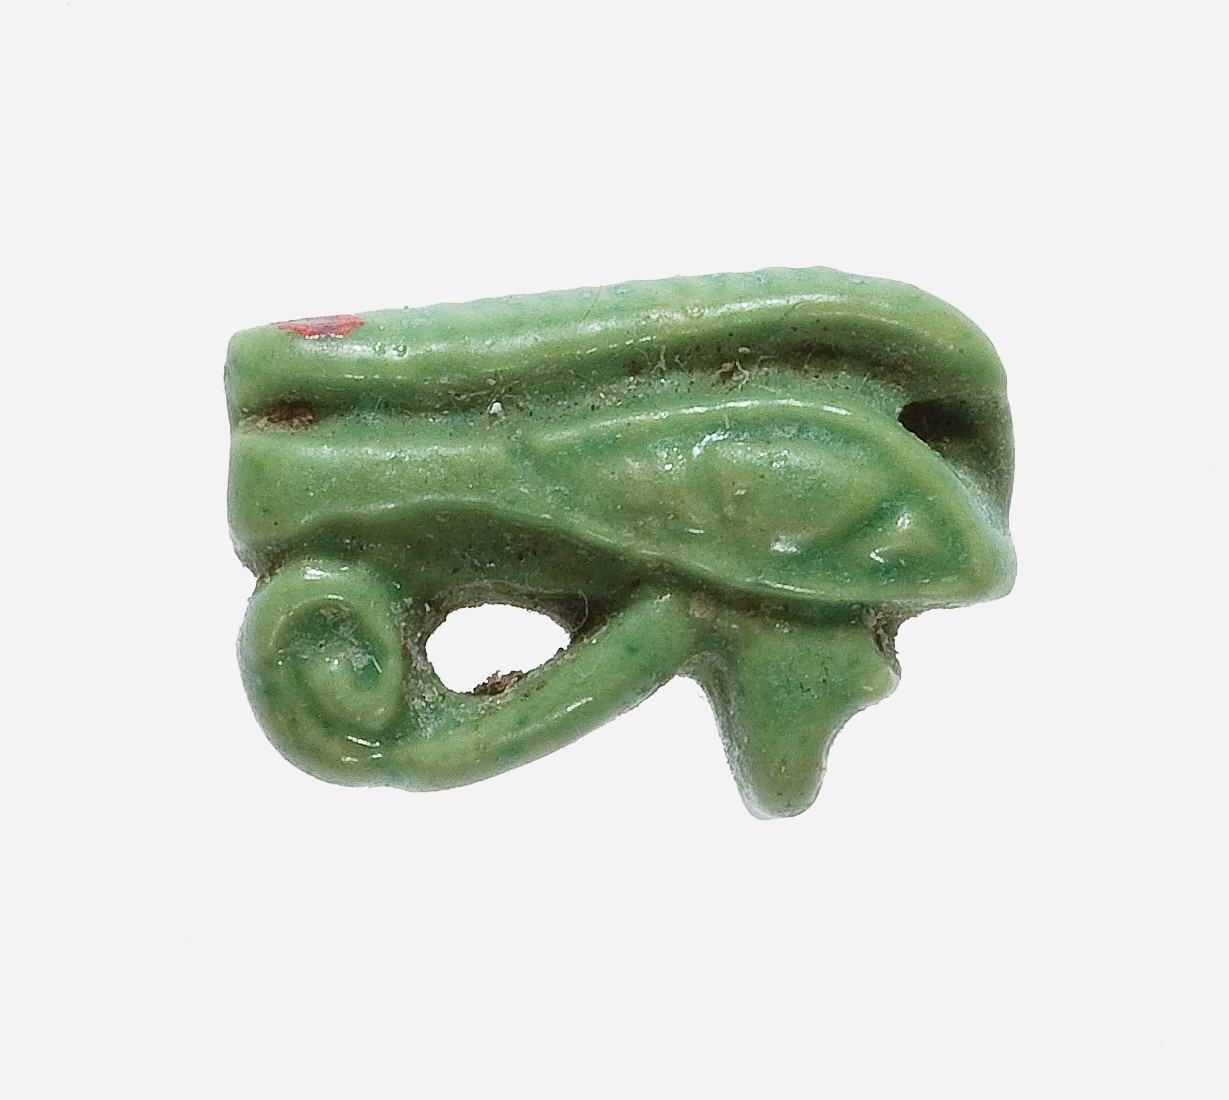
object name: amulet, wedjat eye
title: Wedjat Eye Amulet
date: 1390-1352 BCE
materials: faience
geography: egypt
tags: eyes